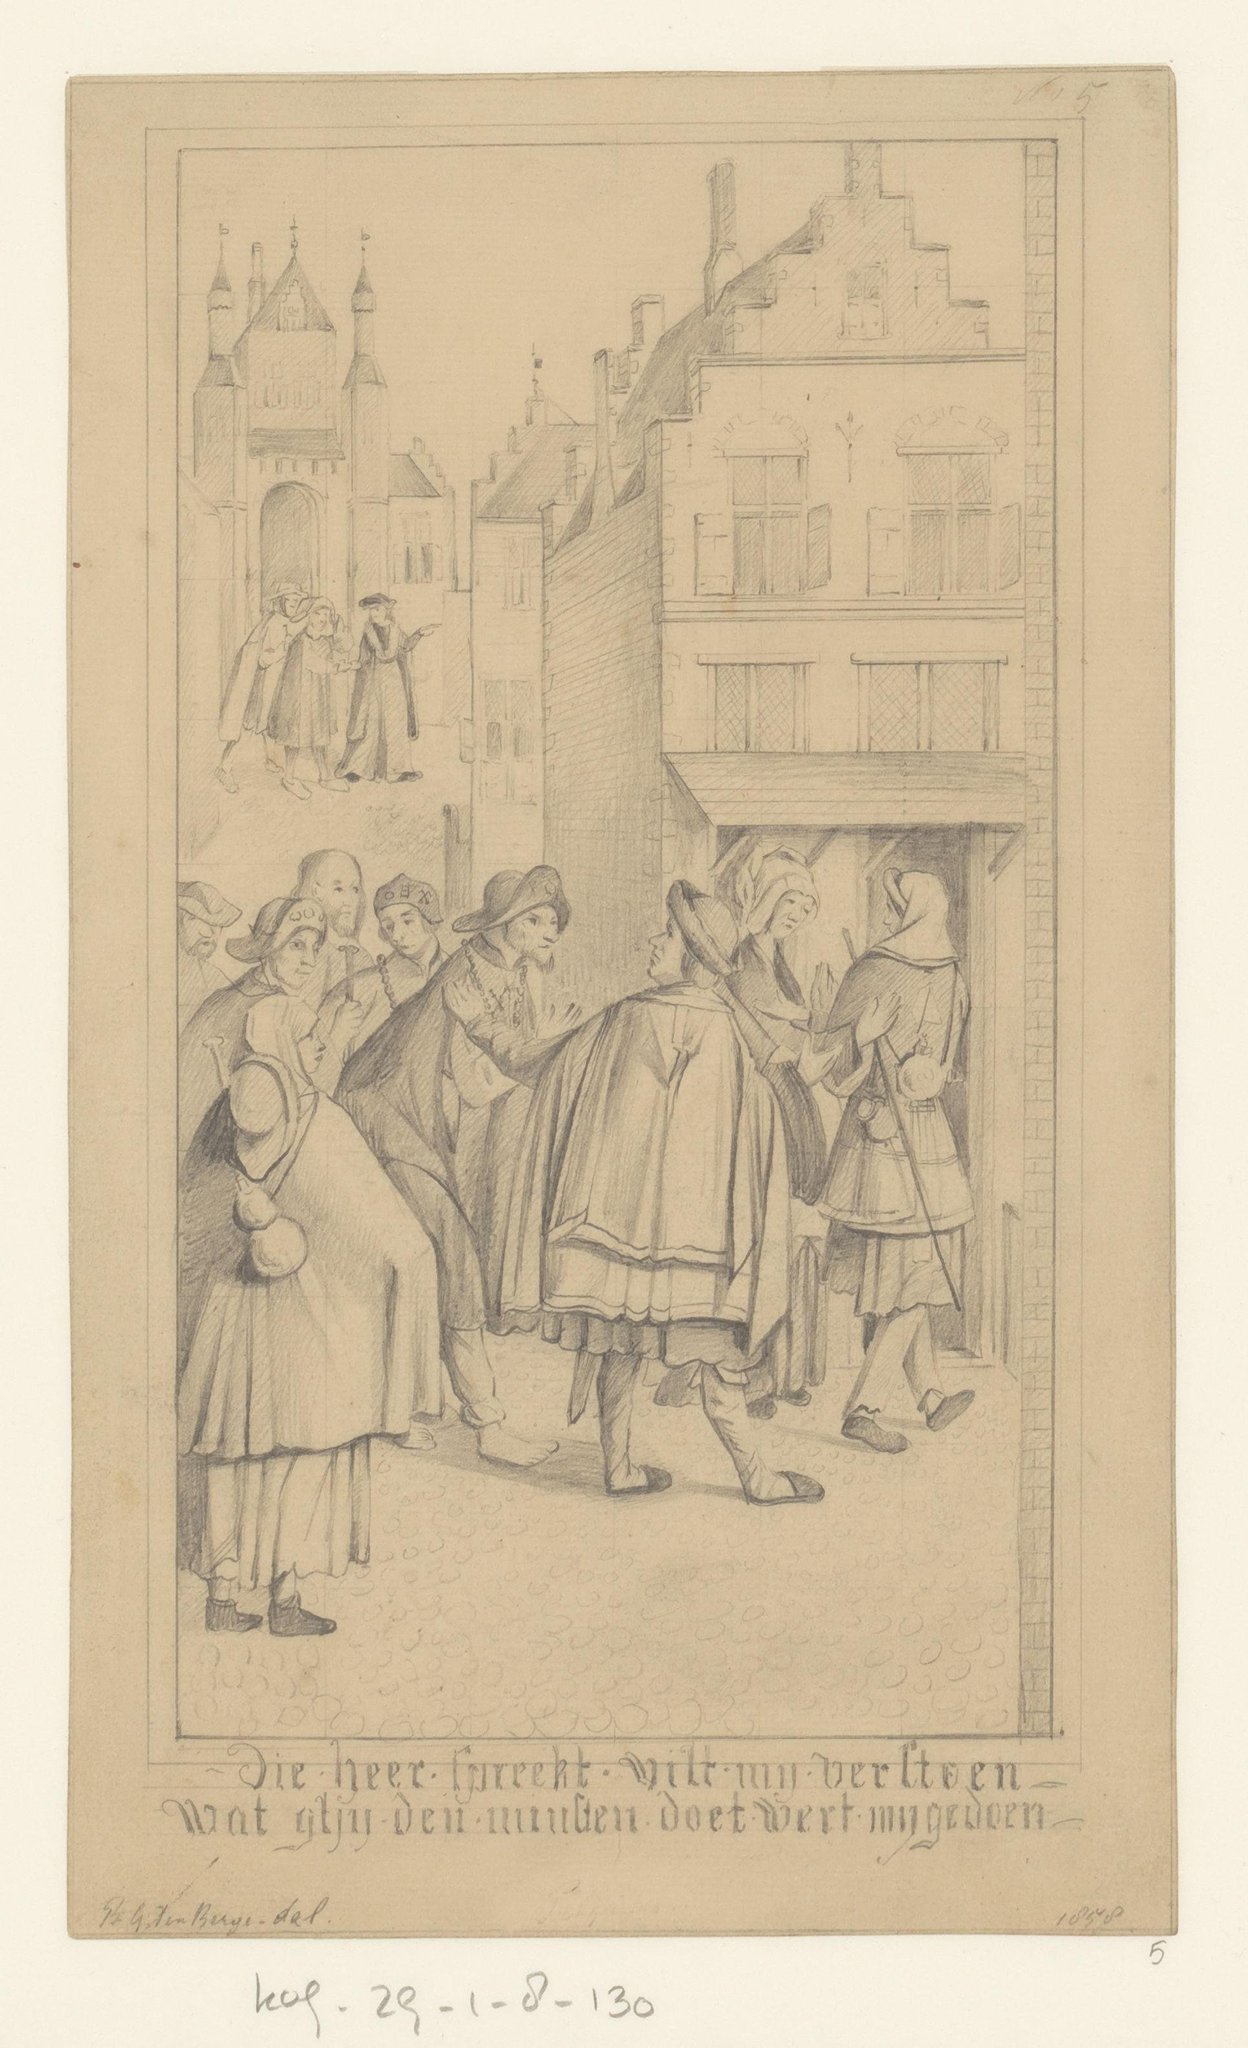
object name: drawing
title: Het herbergen van de reizigers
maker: bernardus gerardus ten berge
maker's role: draughtsman, print maker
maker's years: 1835-1875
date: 1845-1875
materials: paper, pencil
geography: netherlands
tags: sheltering strangers, 'hospes colligitur' ~ one of the (seven) acts of mercy, charitable works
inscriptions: collector's mark: Lugt 1641a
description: Het herbergen van de reizigers. Een man en een vrouw verwelkomen bedevaartgangers in hun huis. Christus bevindt zich tussen de pelgrims. Op de achtergrond wijst een man twee reizigers naar een rustplaats. Onderdeel van een reeks van zeven tekeningen naar de schilderijen met voorstellingen van de zeven werken van barmhartigheid in de collectie van het Rijksmuseum. Onderwerpsrubrieken binnen de Atlas Zeden en Gewoonten: Armwezen en Liefdadigheid.